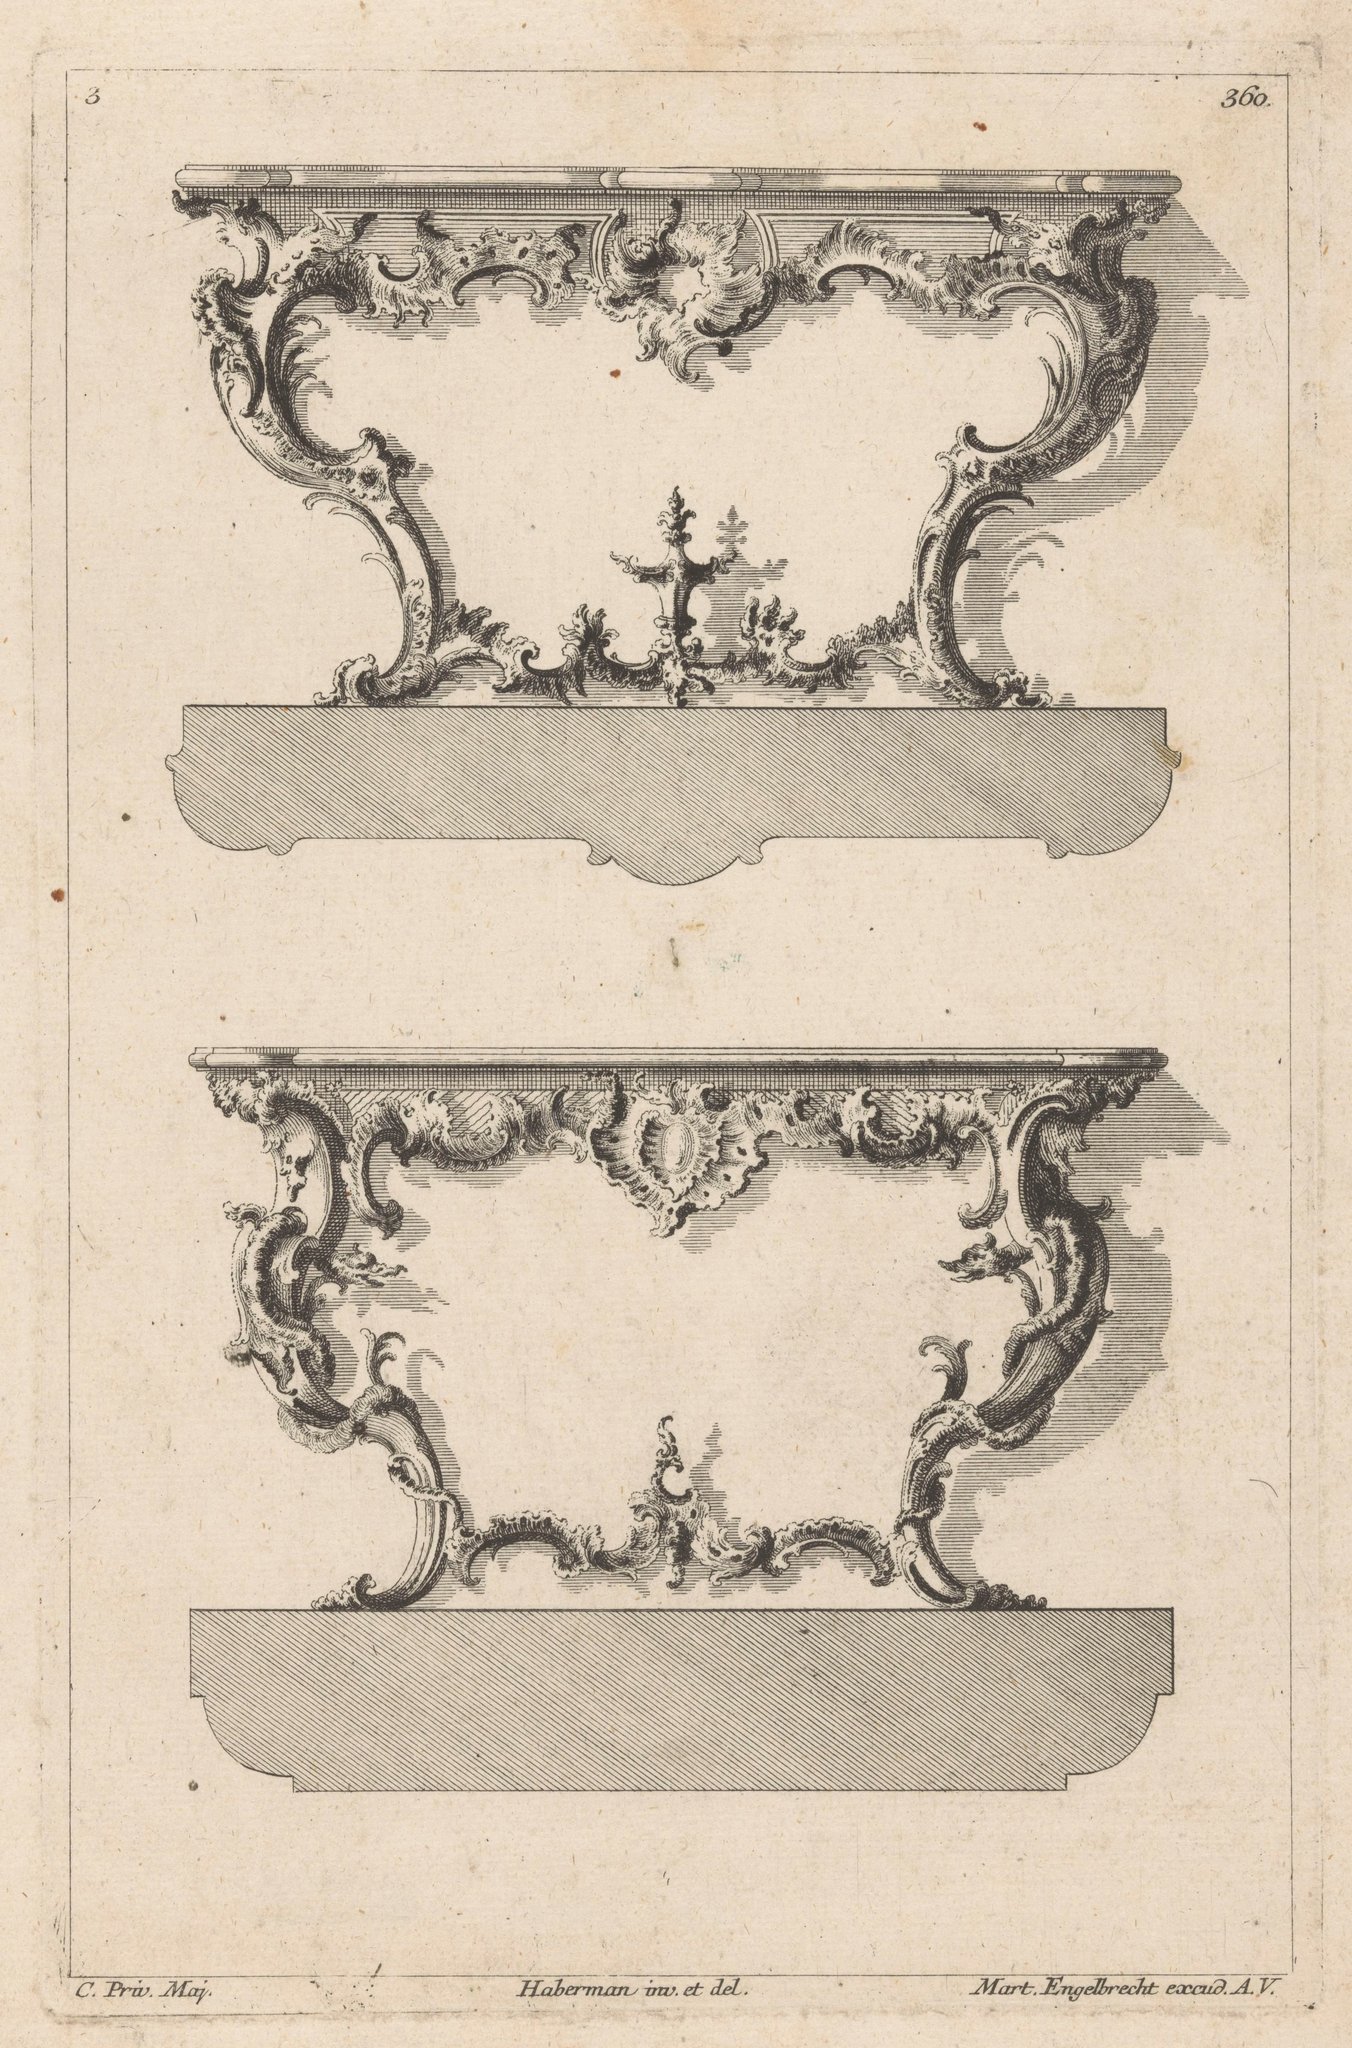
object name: print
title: Wandtafels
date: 1731-1756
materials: paper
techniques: engraving, etching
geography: augsburg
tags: rocaille ornament, table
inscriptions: collector's mark: Lugt 2228, collector's mark: Lugt 2760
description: Voor- en bovenaanzicht van twee wandtafels met fantasiedieren en rocaille ornamenten. Prentnummer 360.